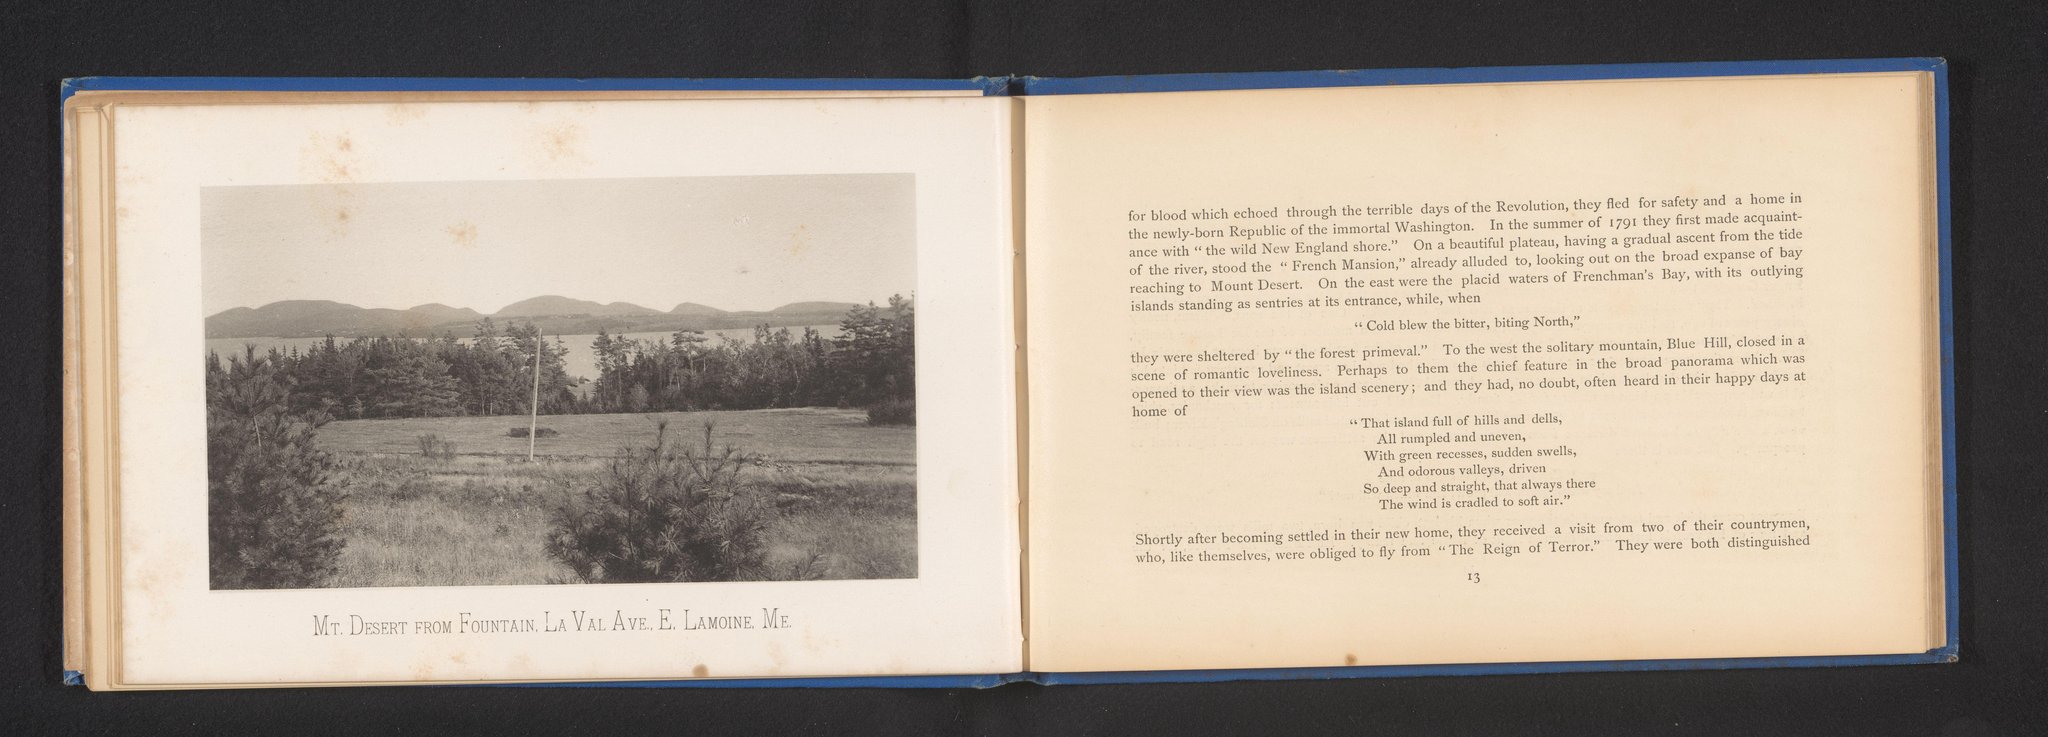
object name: photomechanical print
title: Gezicht op Mount Desert Island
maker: Anonymous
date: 1882-1887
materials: paper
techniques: photograph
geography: east lamoine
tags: island, trees